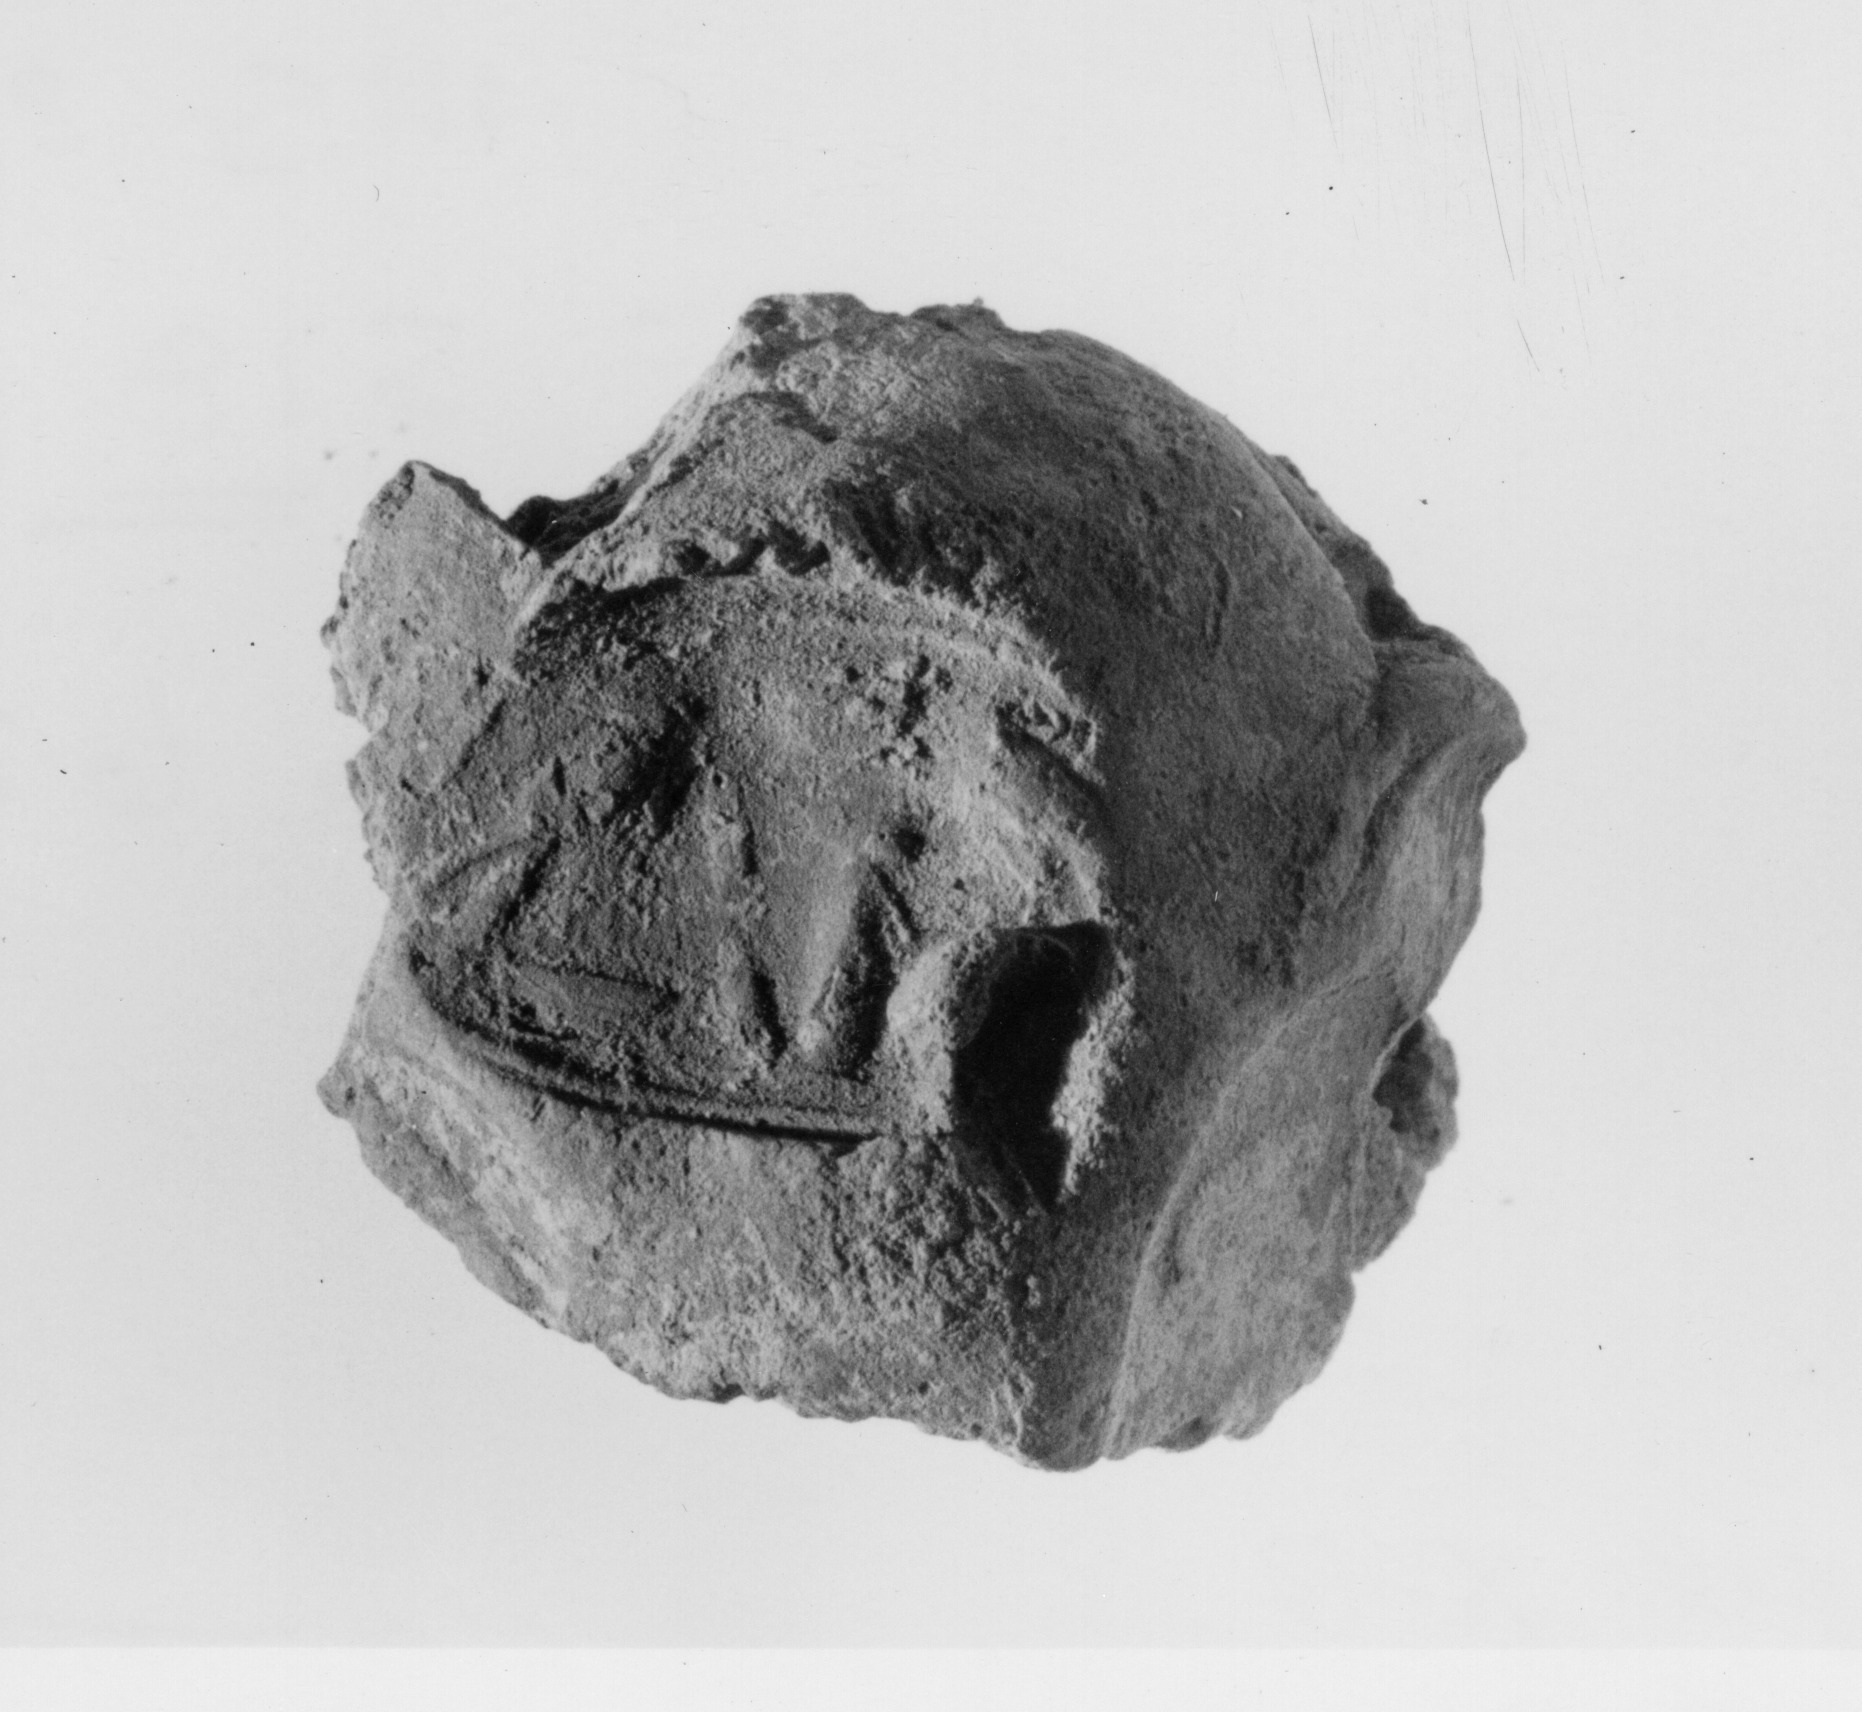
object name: sealing, nebmaatre, amenhotep iii, ptah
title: Document Sealing With Multiple Seal Impressions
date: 1390-1352 BCE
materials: mud